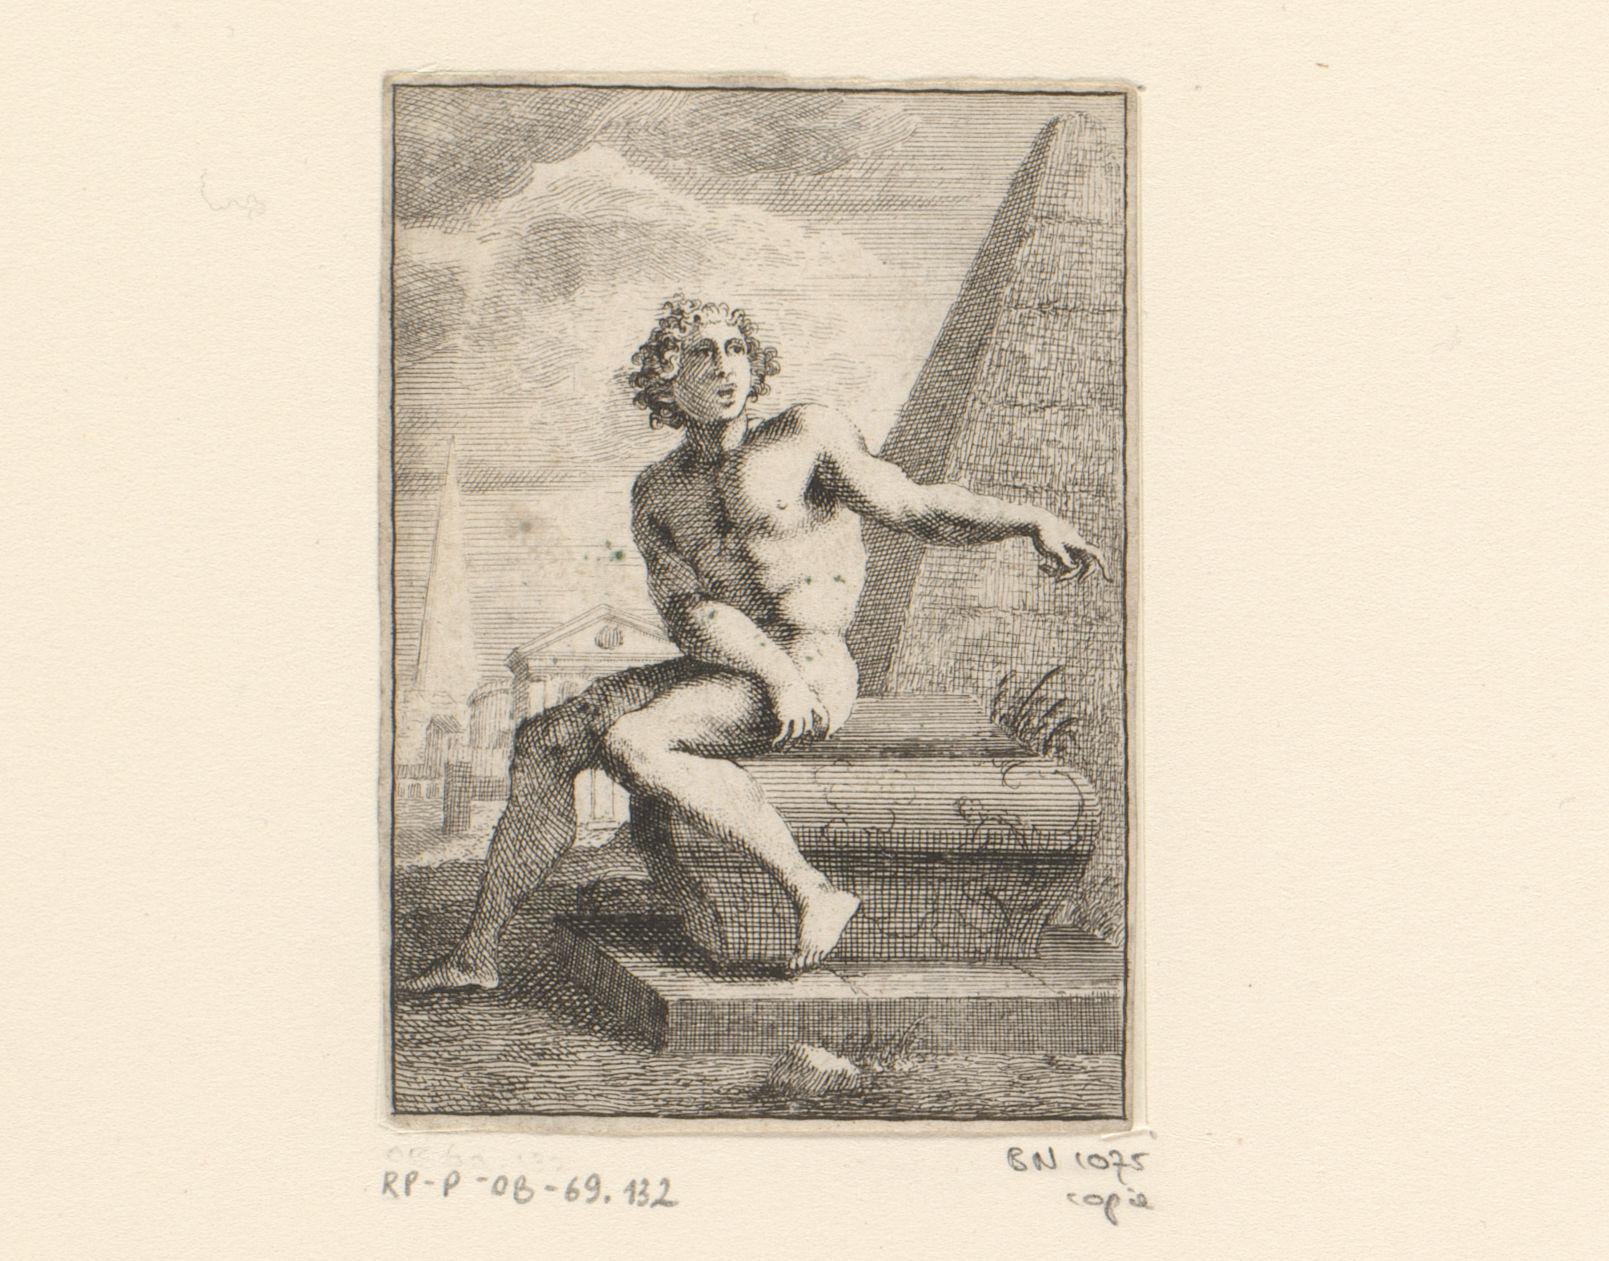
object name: print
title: Memnon bij een piramide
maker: Anonymous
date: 1647-1714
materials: paper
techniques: engraving, etching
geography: france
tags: (story of) memnon, son of aurora, pyramid (historical grave form)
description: Deze prent is een anonieme kopie naar de originele prent van Sébastien Leclerc.